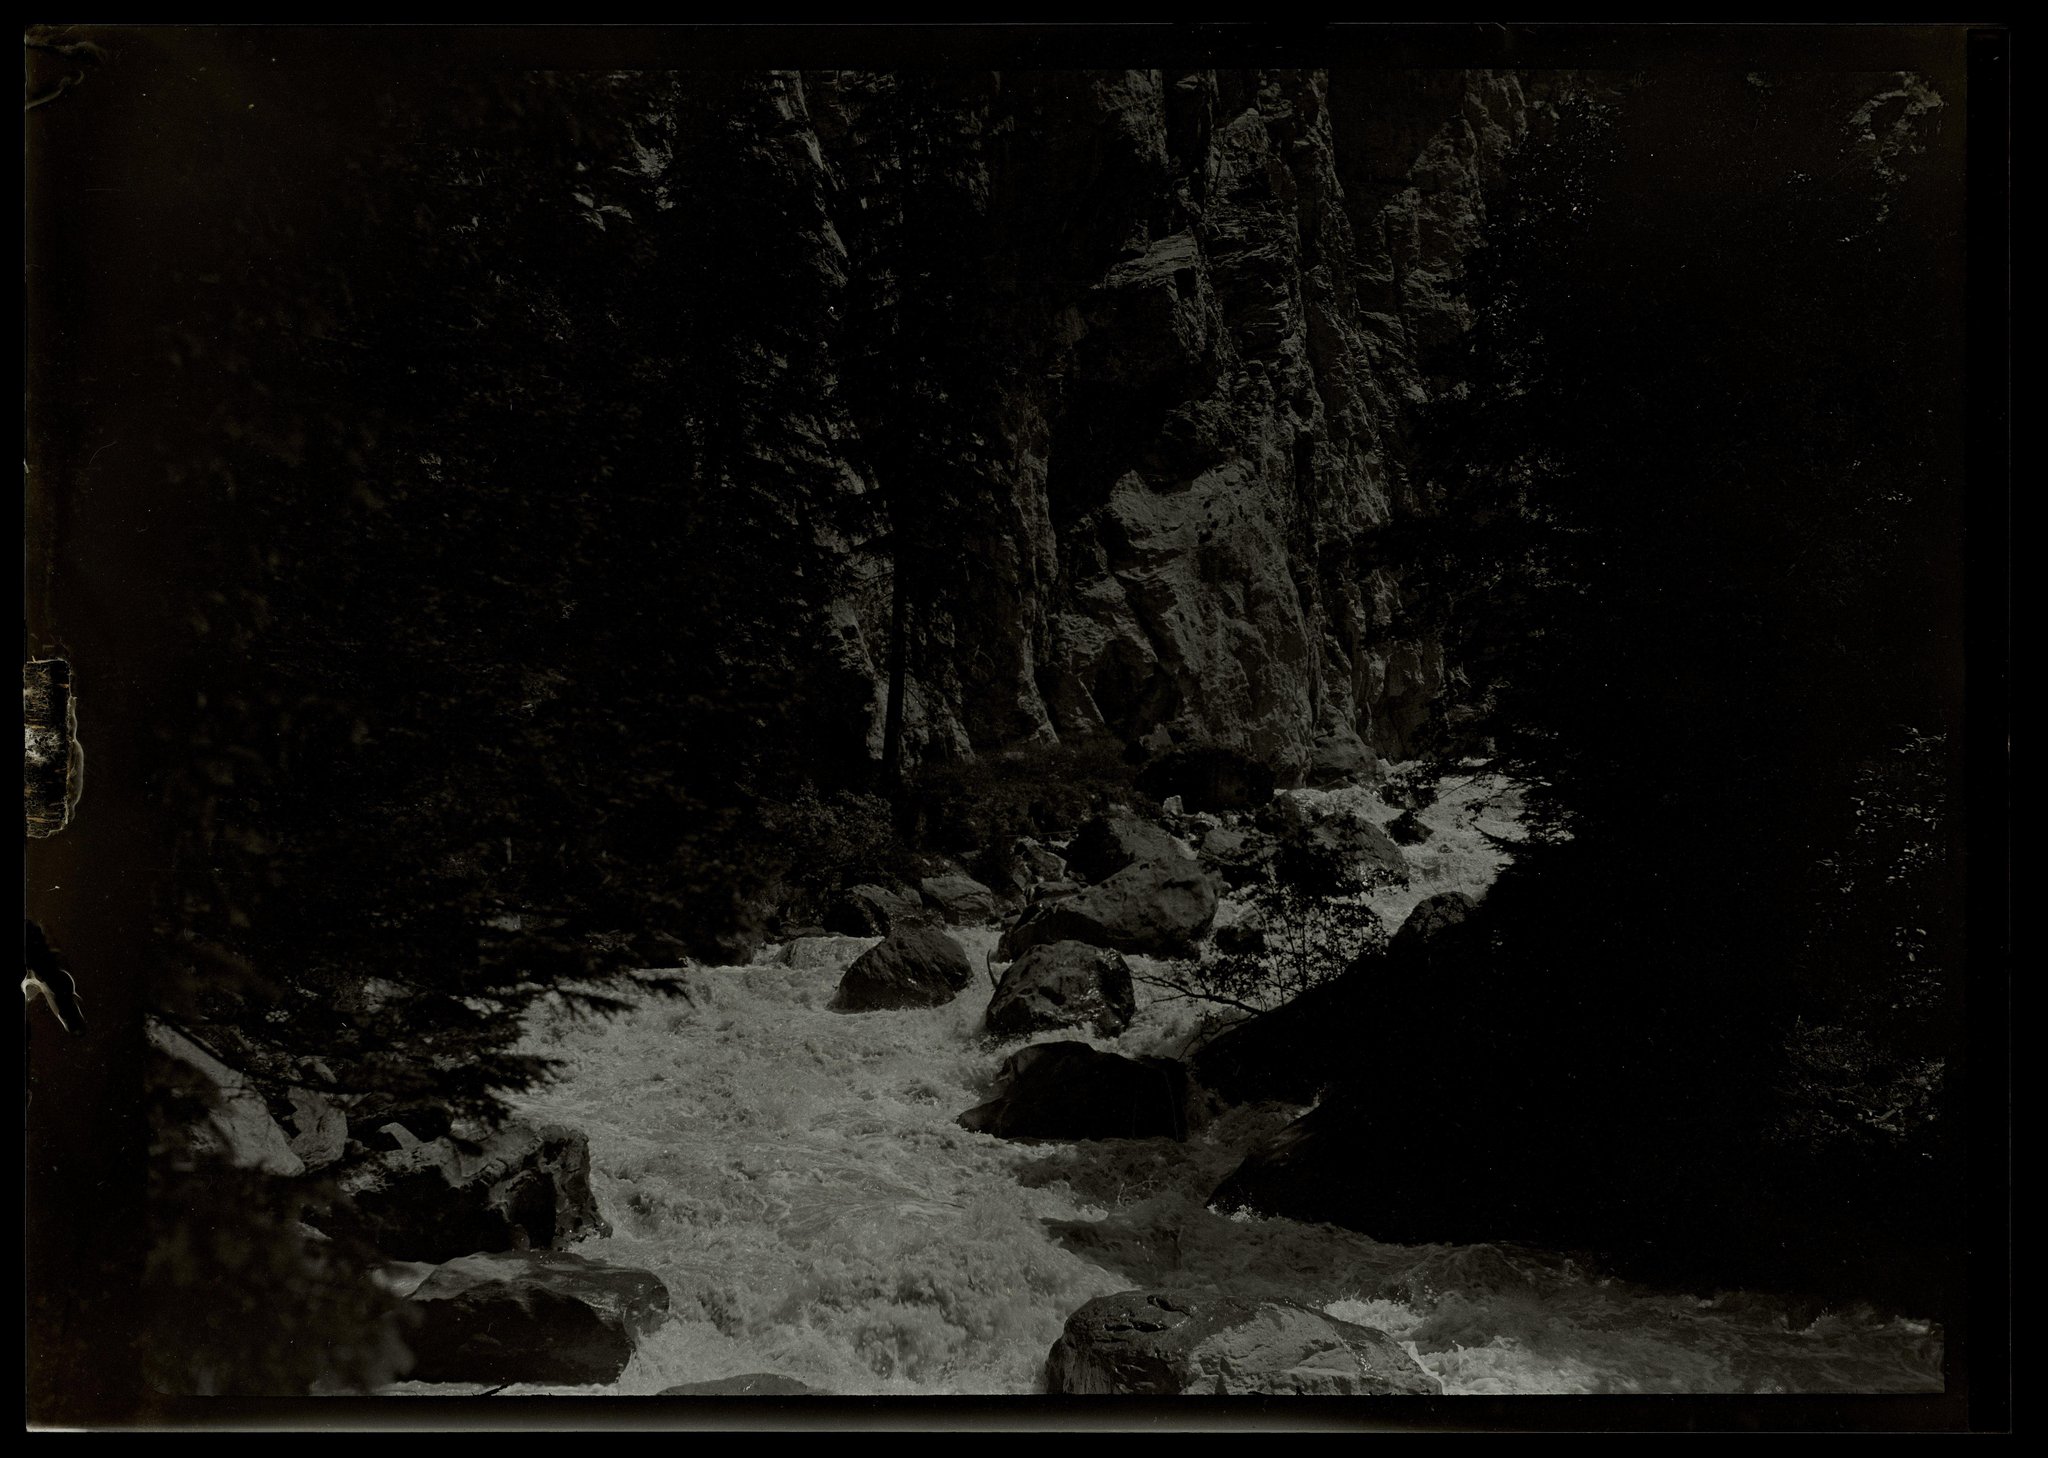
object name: photograph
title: Filmnegatief met opname van Zermatt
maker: Anonymous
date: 1921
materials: film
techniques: gelatin silver negative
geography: zermatt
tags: zermatt